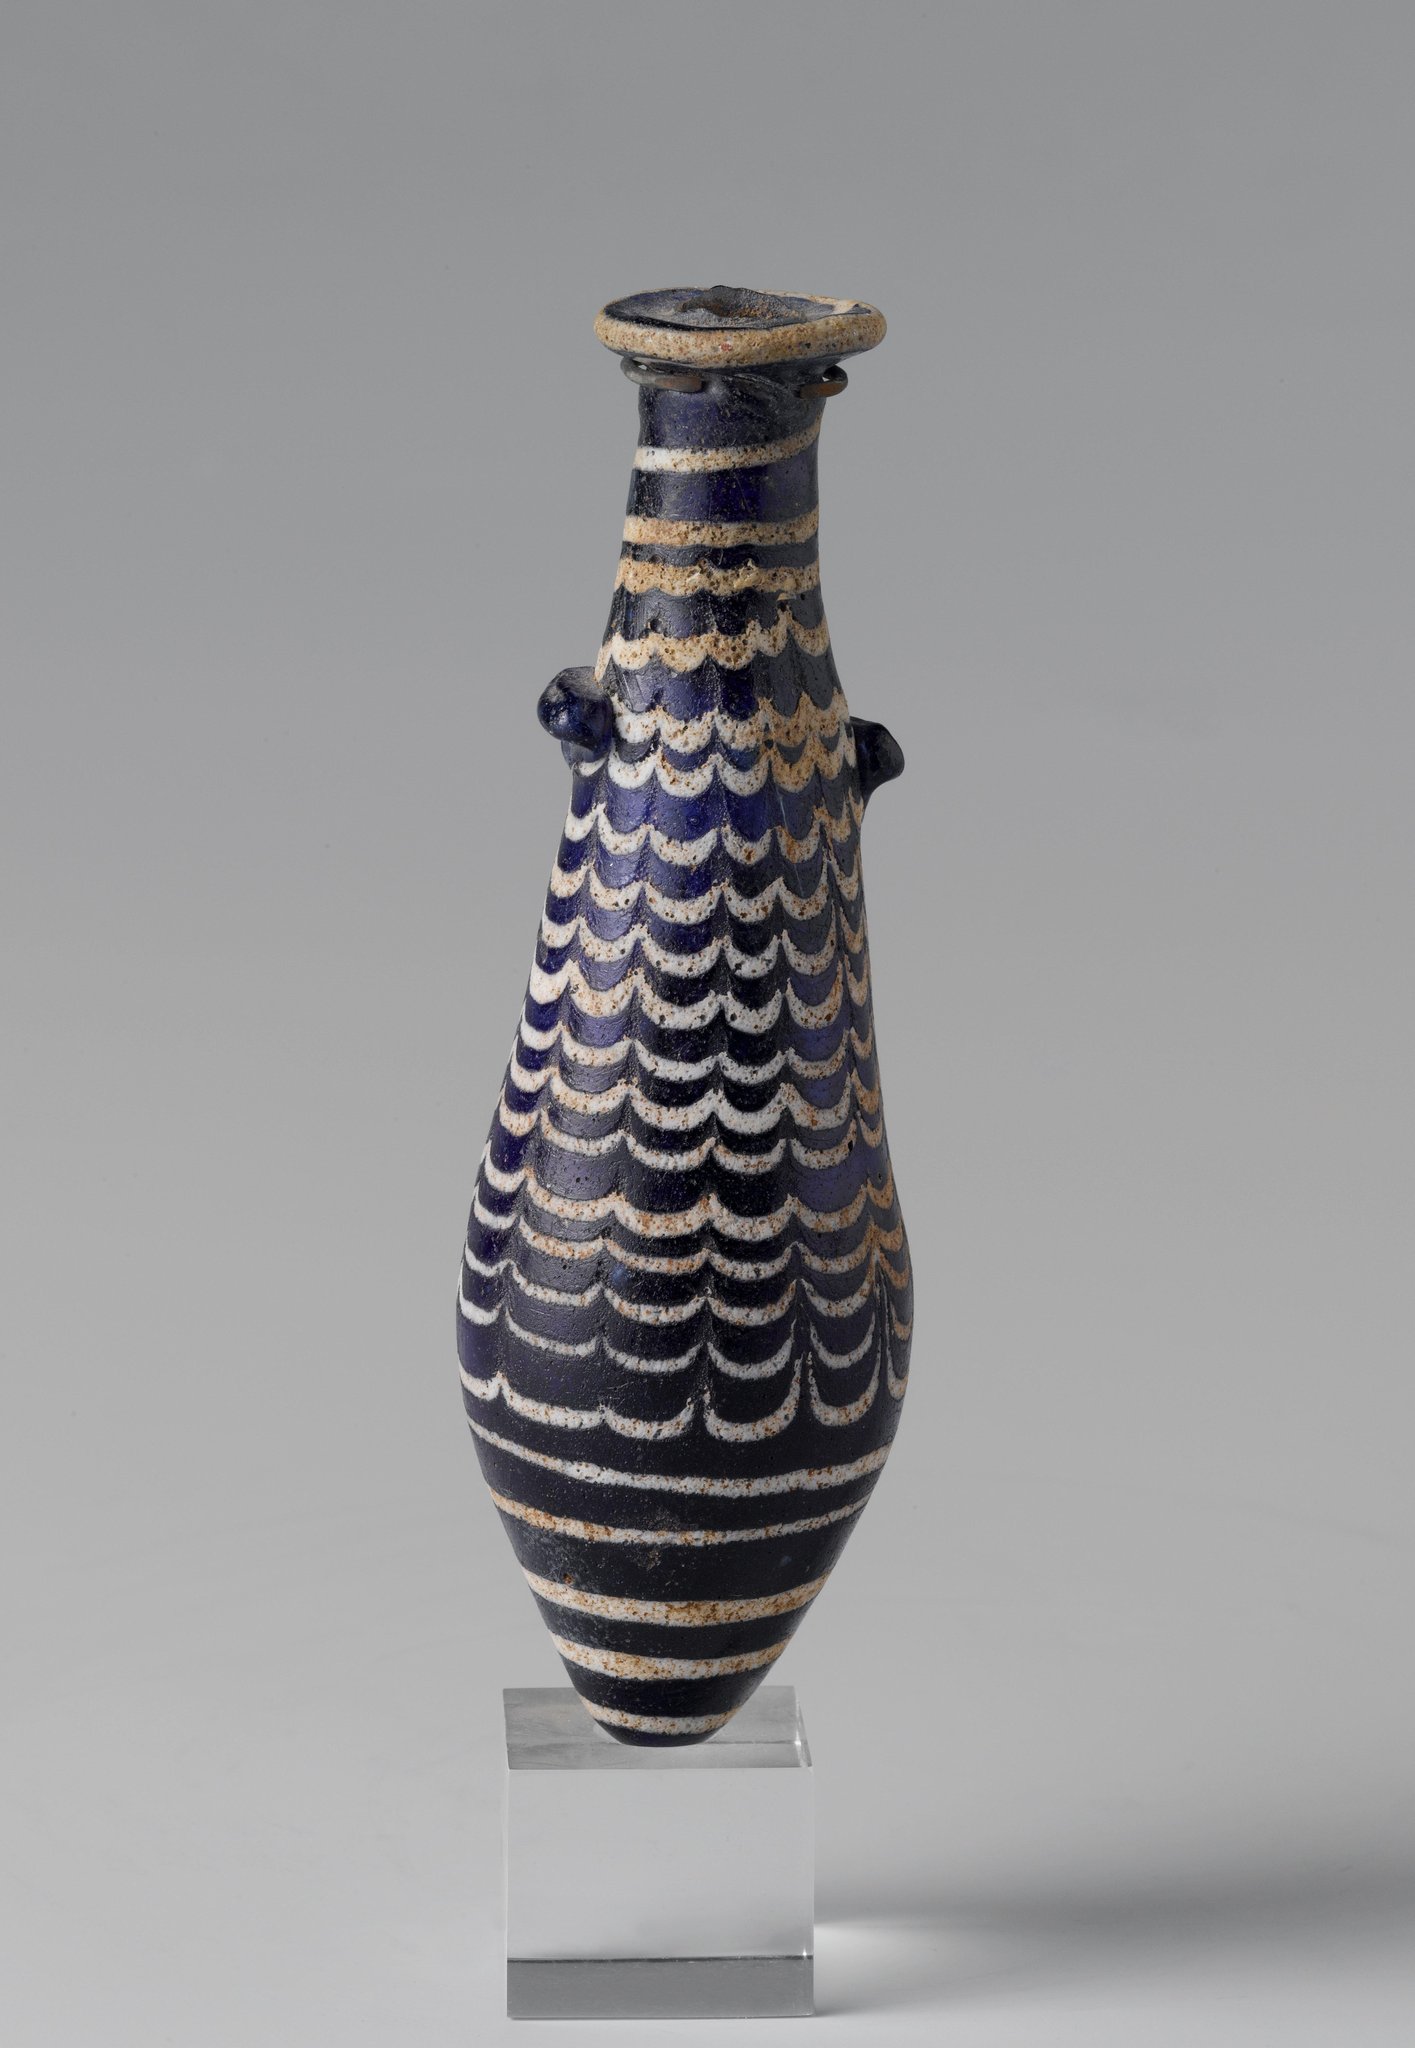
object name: vase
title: Kleine duppelvormige vaas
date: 700-1399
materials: glass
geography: egypt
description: Dikwandige druppelvormige vaas zonder voet of voetring en met een vlakke lip. Aan het lichaam zijn op 2/3 twee vlakke oren aangezet. Rond het hele lichaam zijn afwisselend blauwe en witte glasbanen aangebracht, het onderste deel recht en het bovenste golvend.